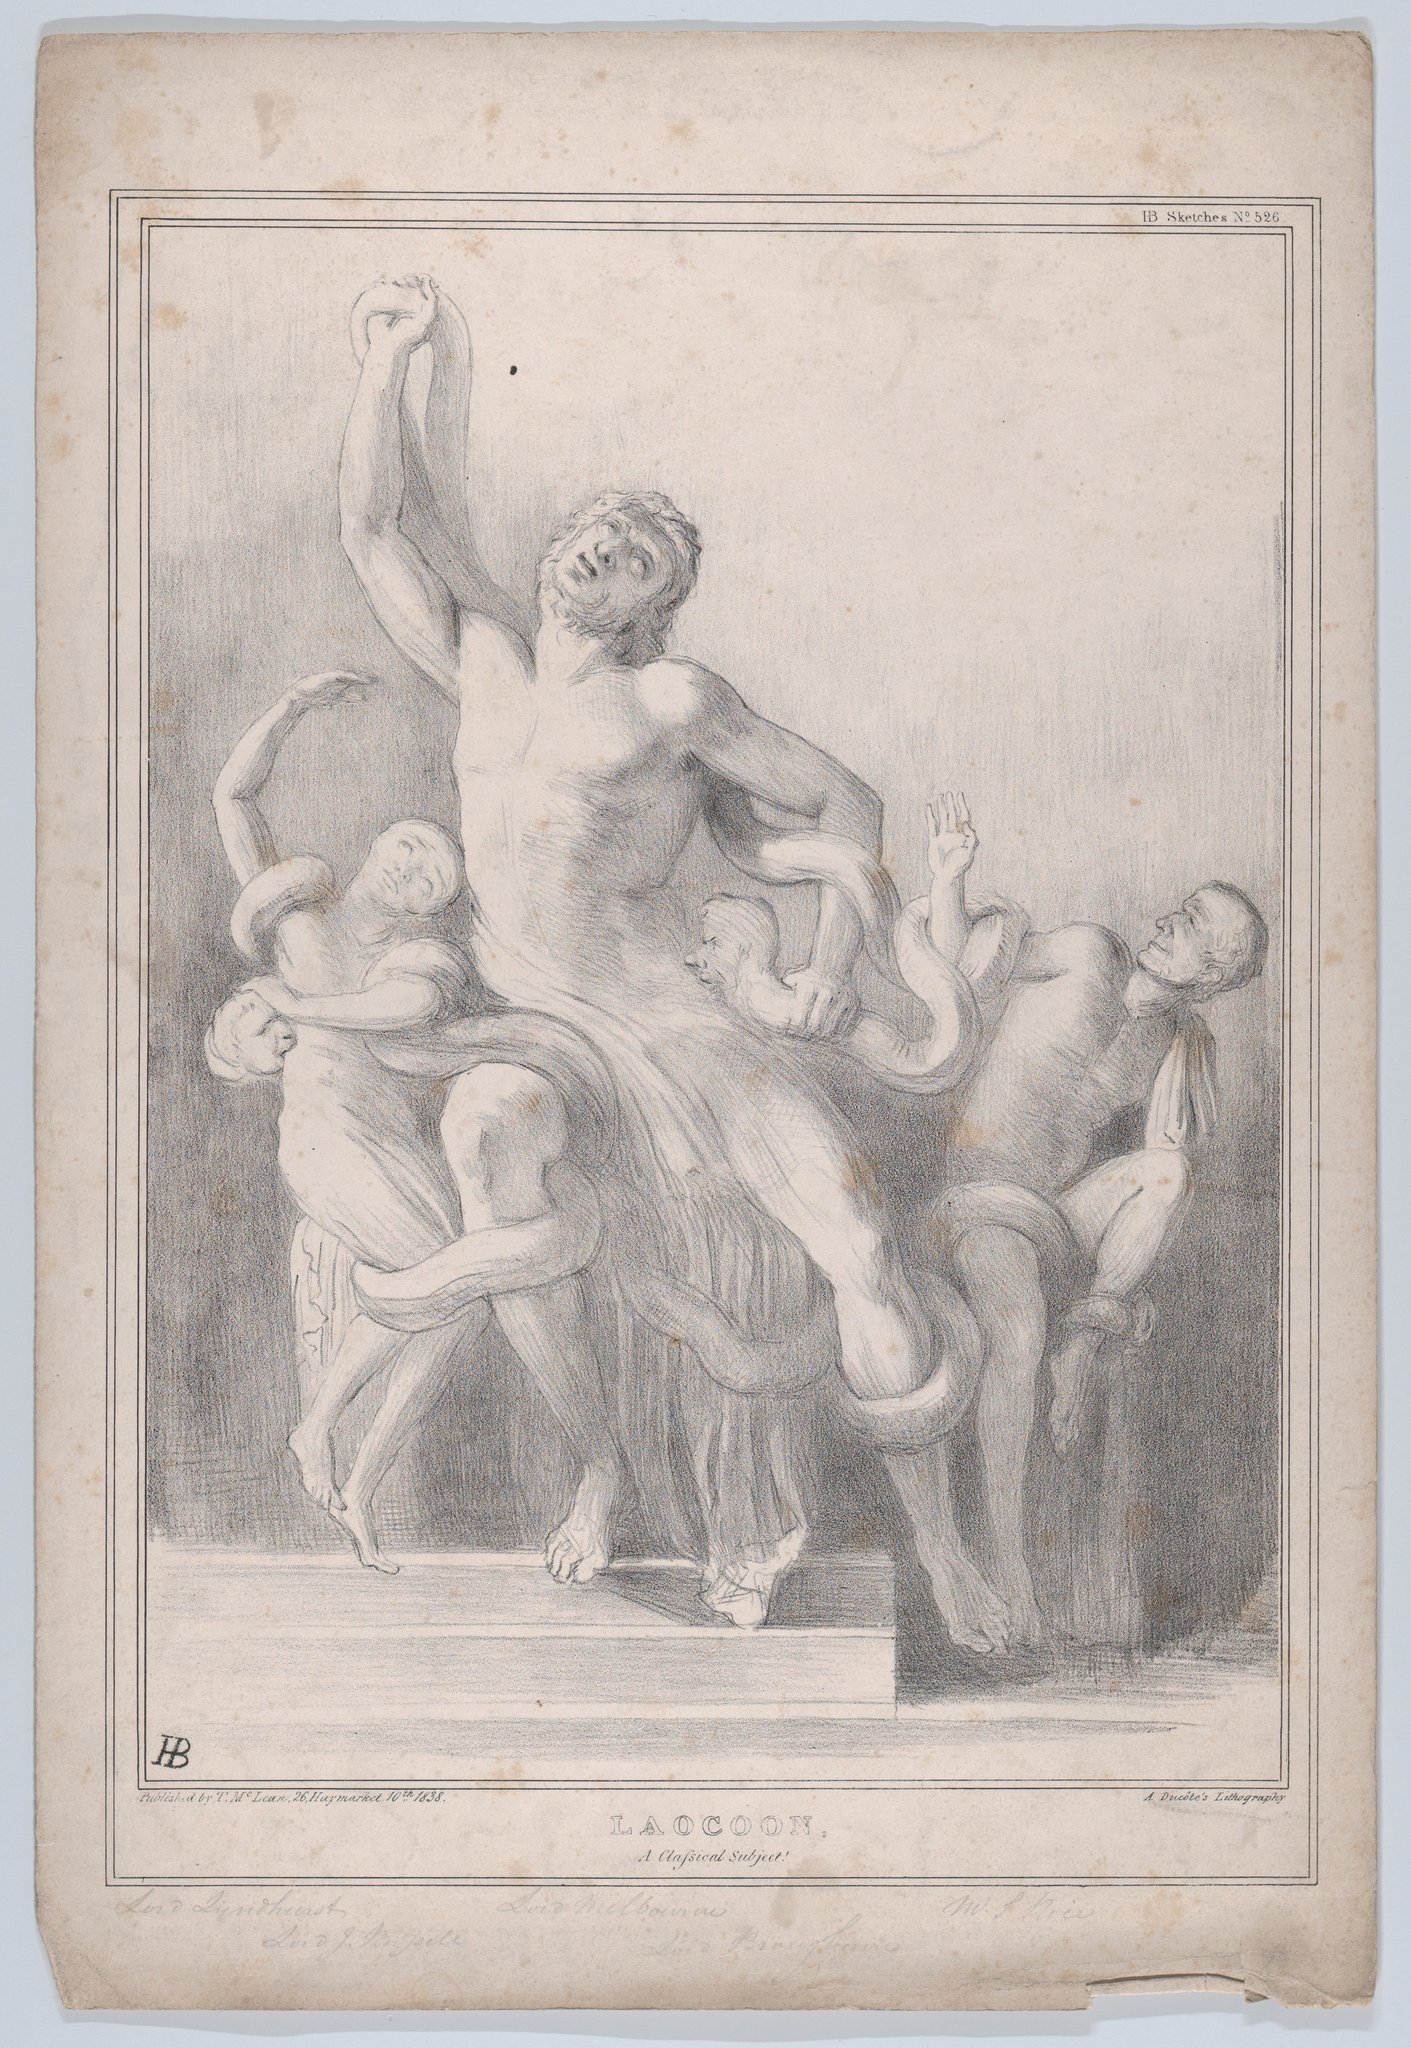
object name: print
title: Laocoon: A Classical Subject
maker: john doyle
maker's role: artist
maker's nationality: irish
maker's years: 1797-1868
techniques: lithograph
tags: men,serpents